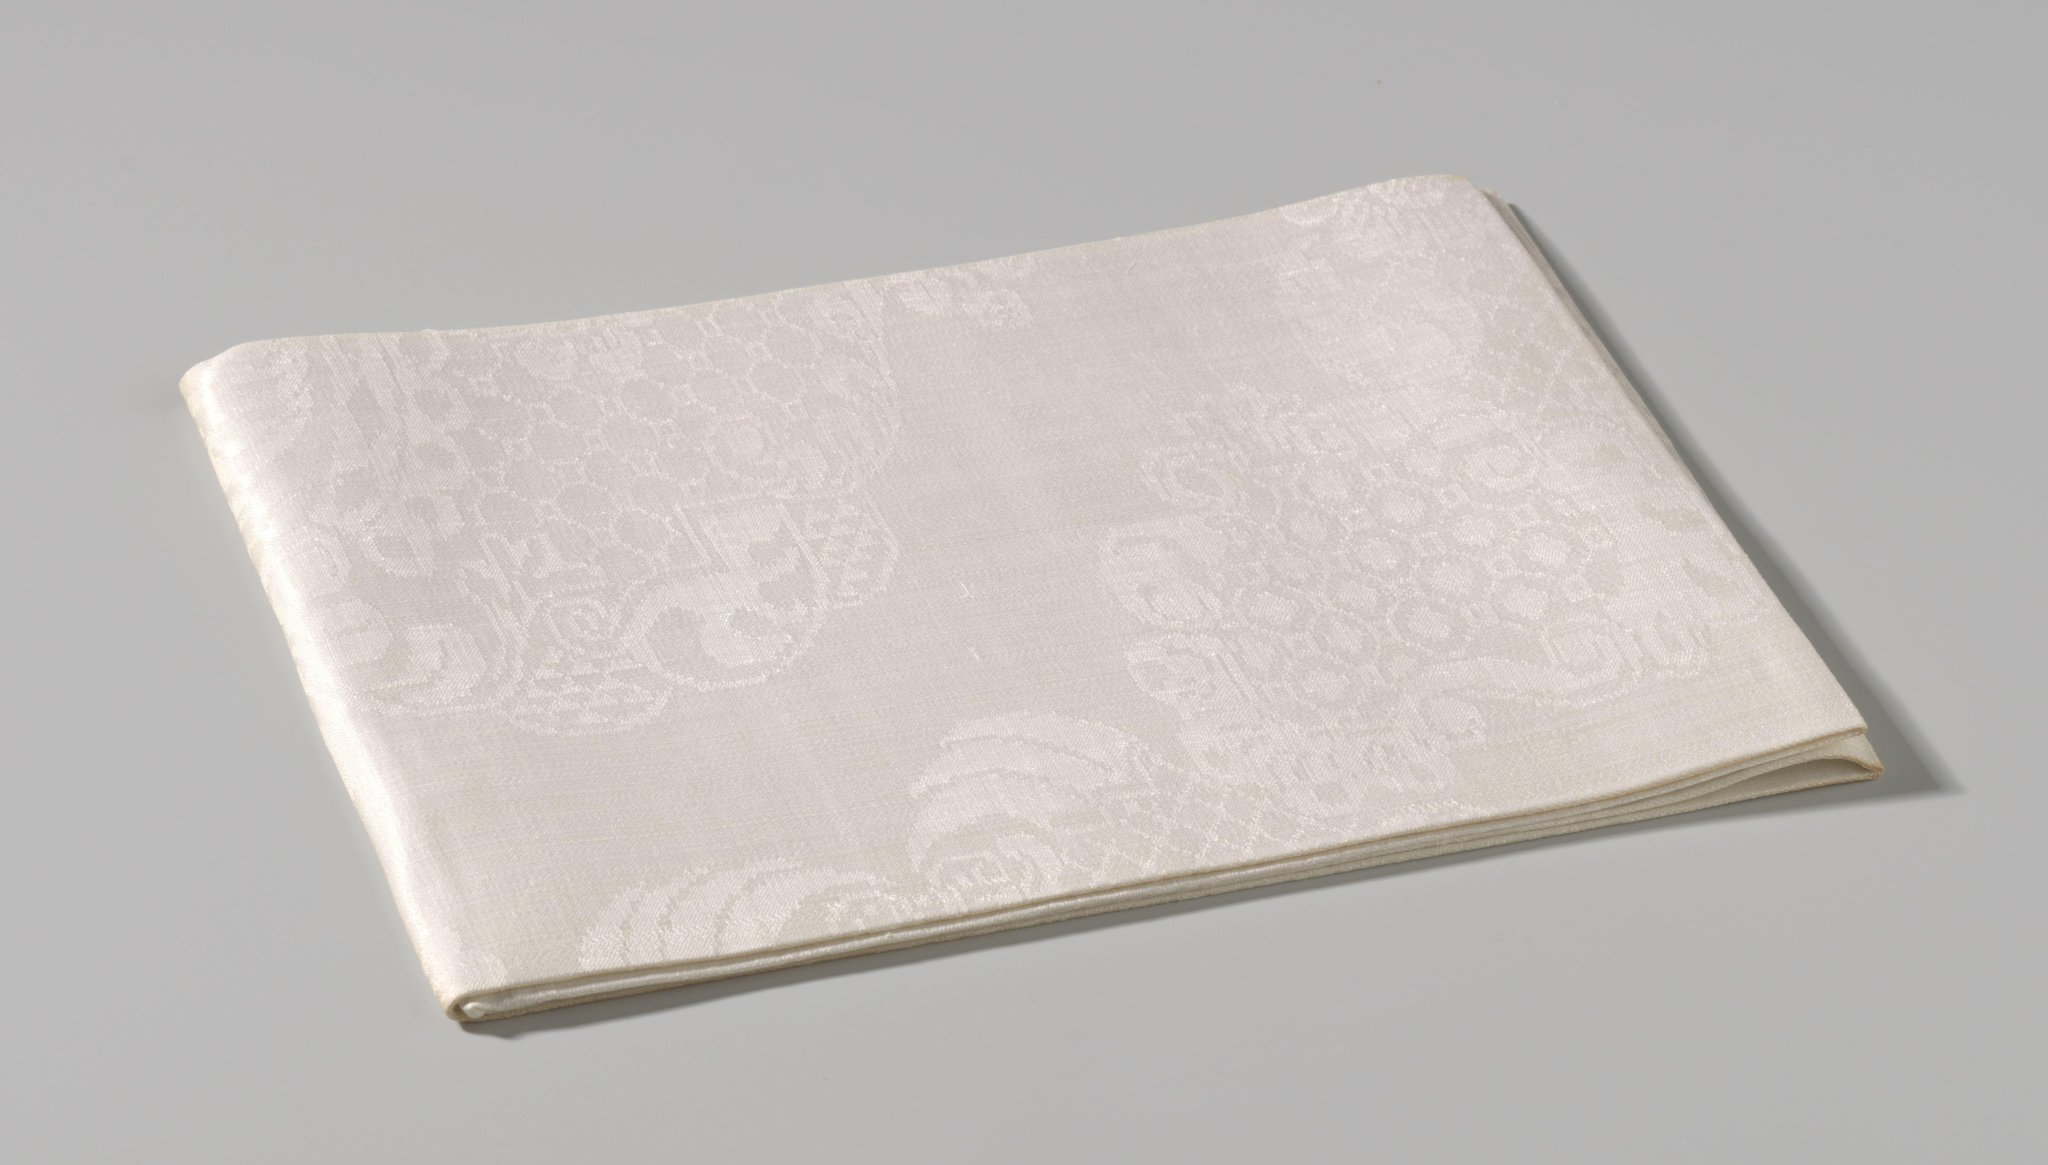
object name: napkin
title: Servet van wit linnendamast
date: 1764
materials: linen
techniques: damask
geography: northern netherlands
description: Wit linnendamasten servet met z.g. kantpatroon, merk kroon G 12